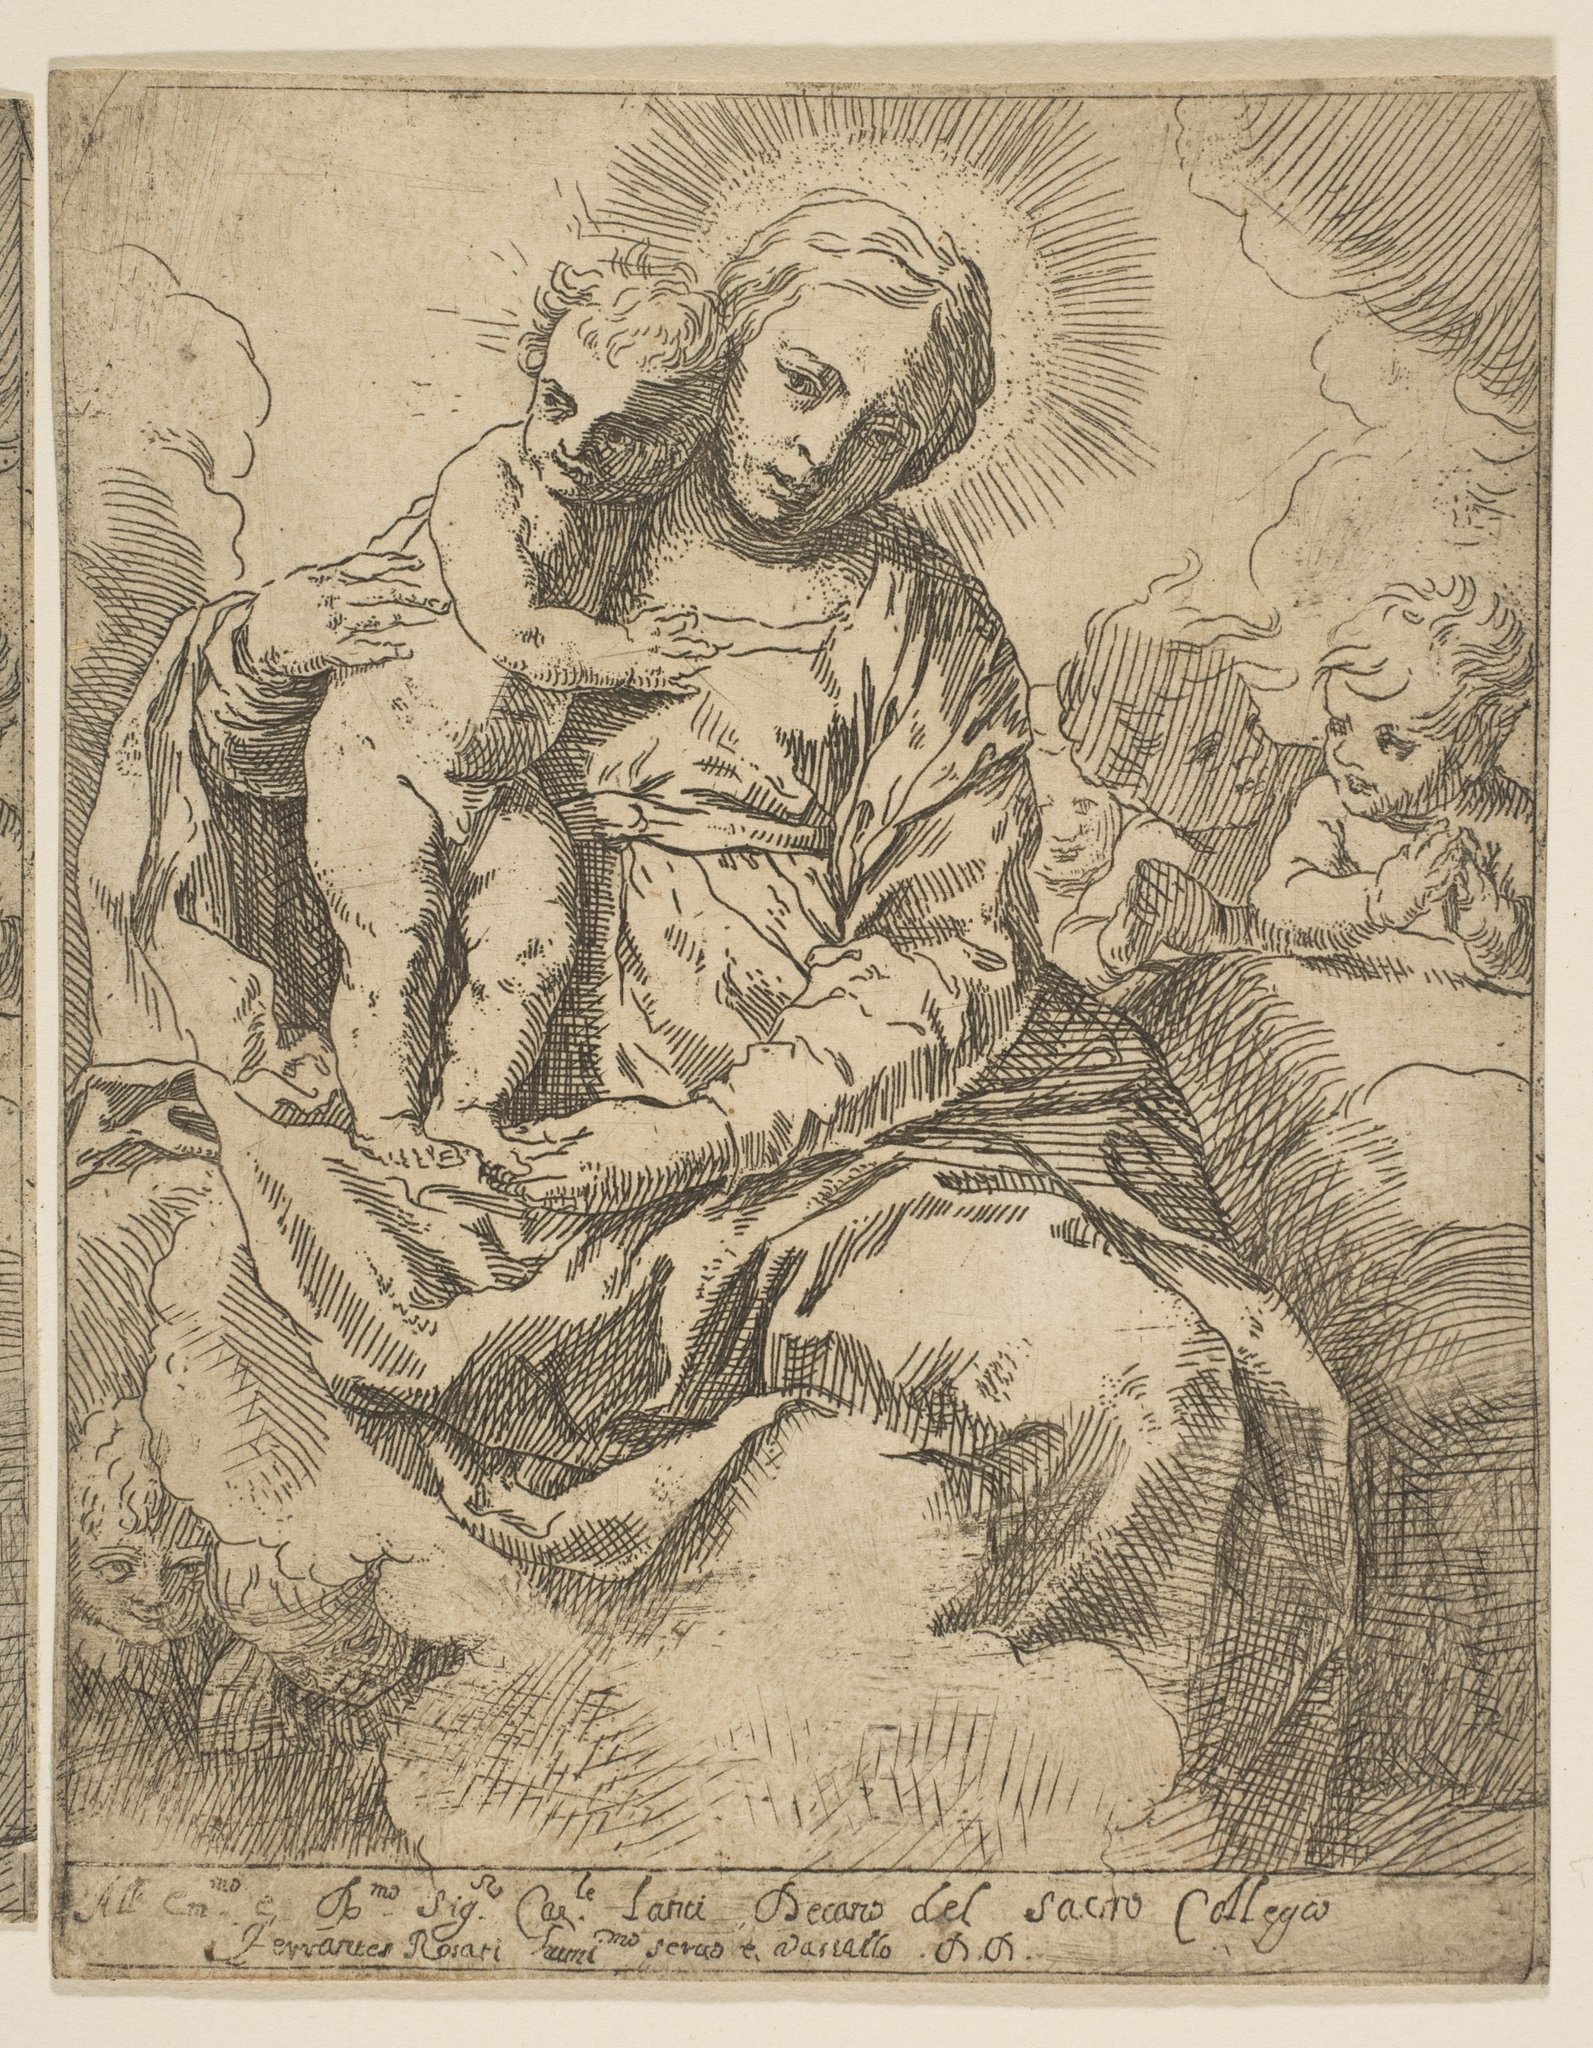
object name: print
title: Madonna and Child seated on clouds and surrounded by angels, copy in reverse after Cantarini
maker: simone cantarini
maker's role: artist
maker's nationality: italian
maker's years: 1612-1648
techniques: etching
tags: angels,madonna and child